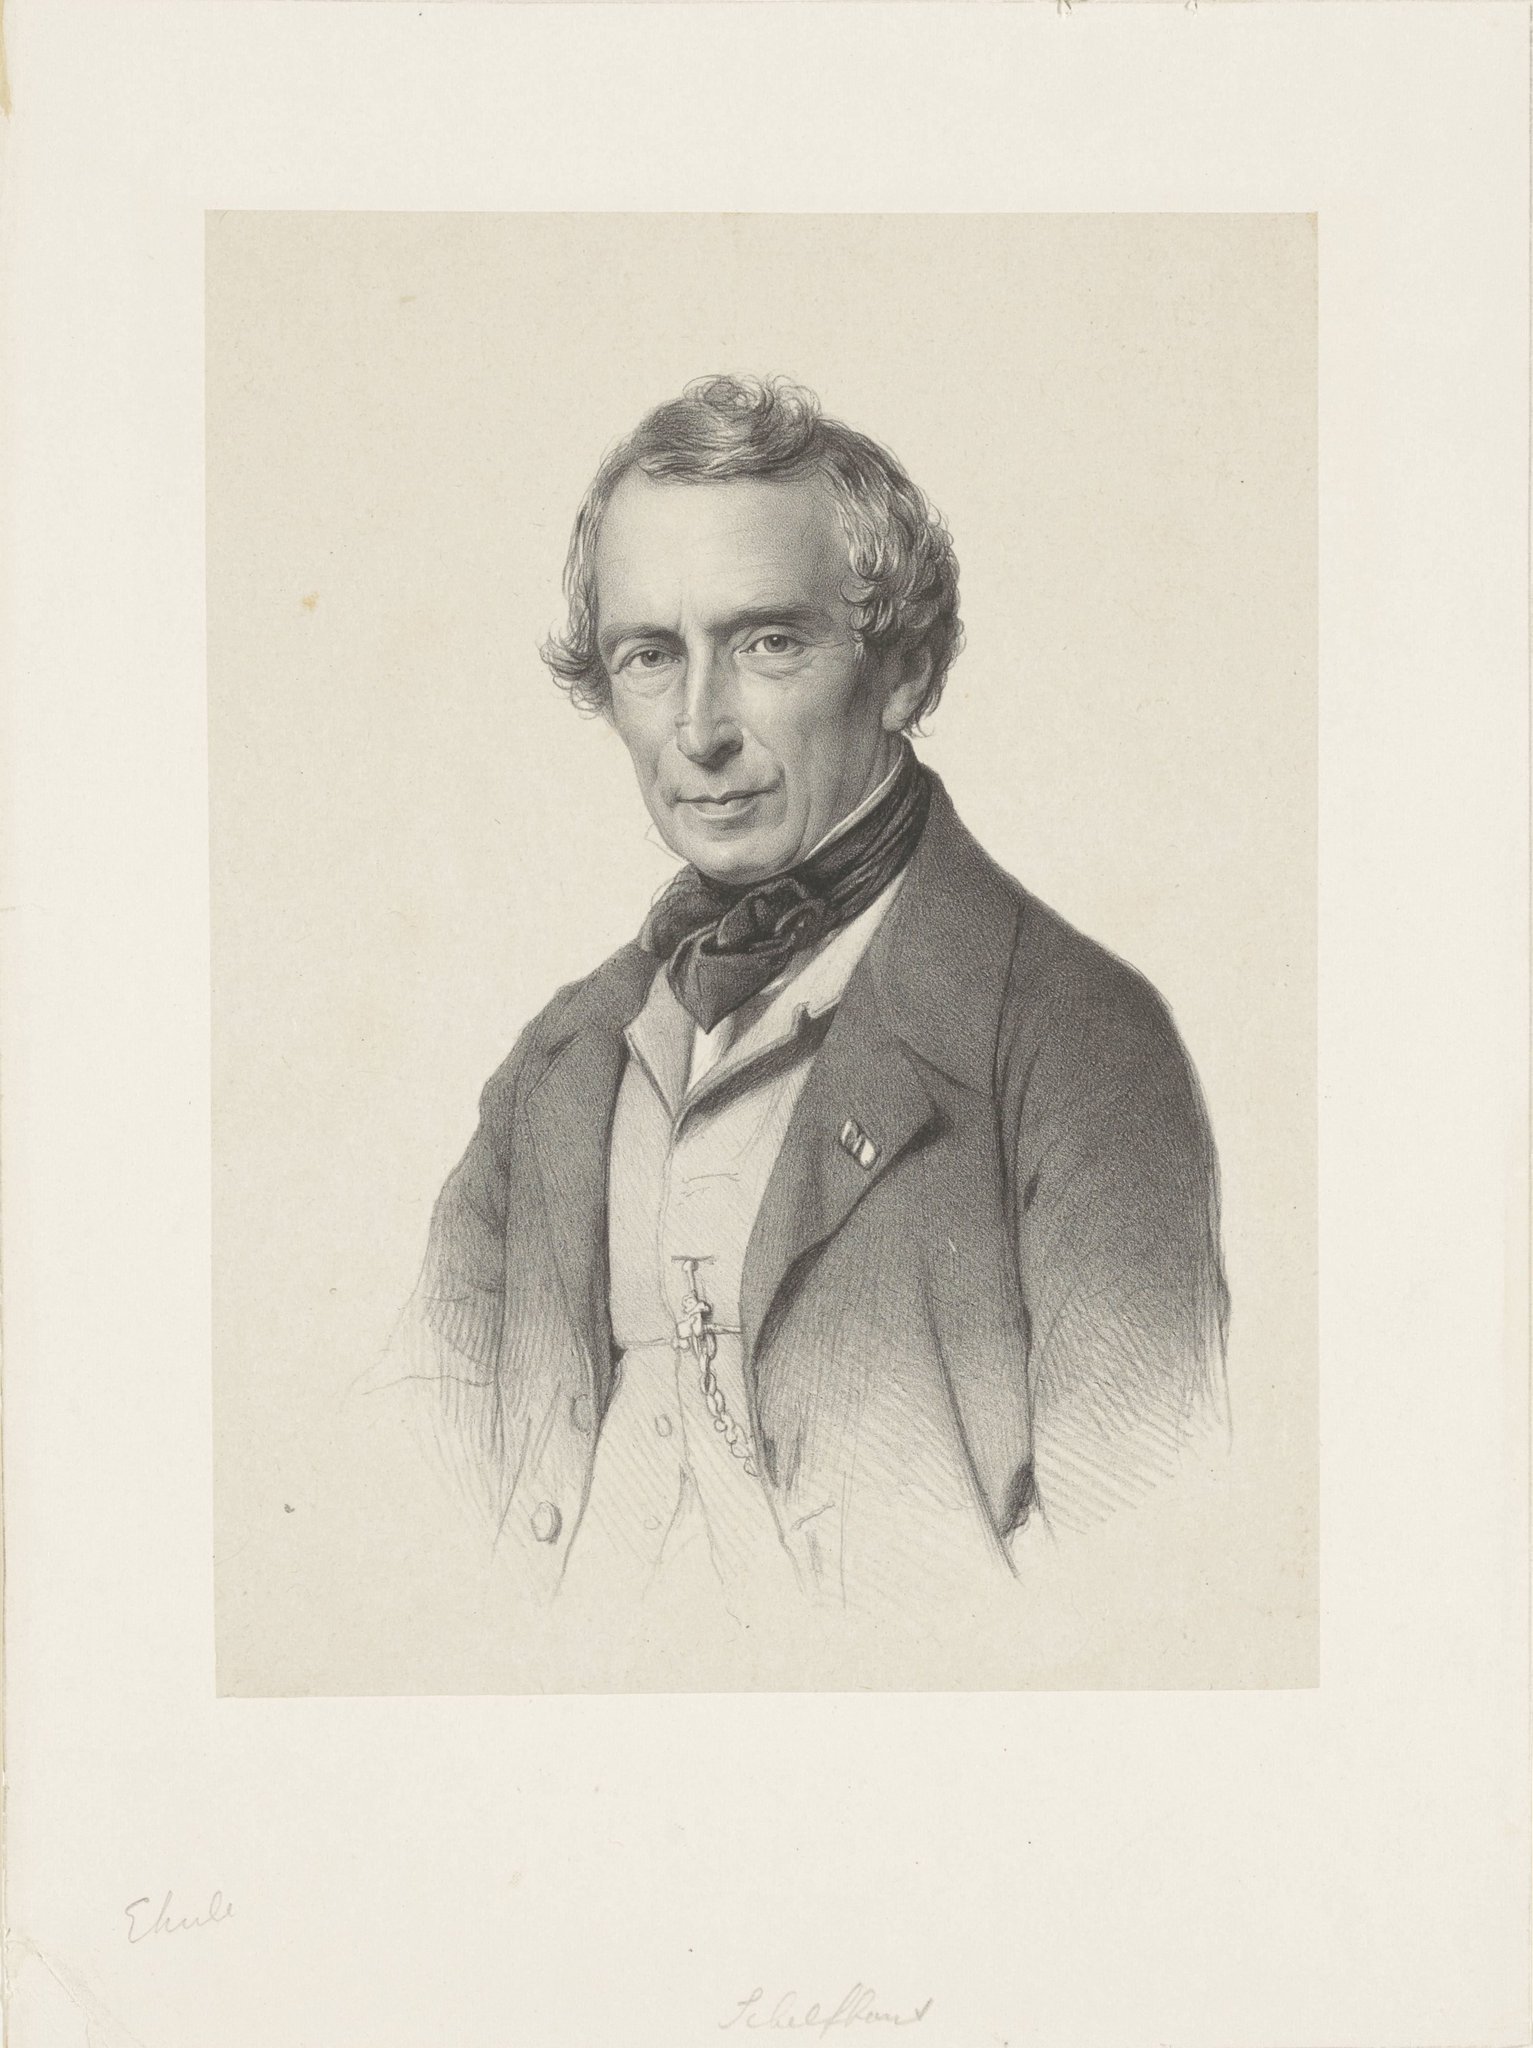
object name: print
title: Portret van Andreas Schelfhout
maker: adrianus johannes ehnle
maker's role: draughtsman, print maker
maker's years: 1819-1863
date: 1854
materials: paper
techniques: lithograph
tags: knighthood order, historical persons (+ (full) bust portrait)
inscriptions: collector's mark: Lugt 2228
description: De geportretteerde draagt een gestrikte das, een horlogeketting aan zijn vest en een ridderorde op de revers van zijn jas.